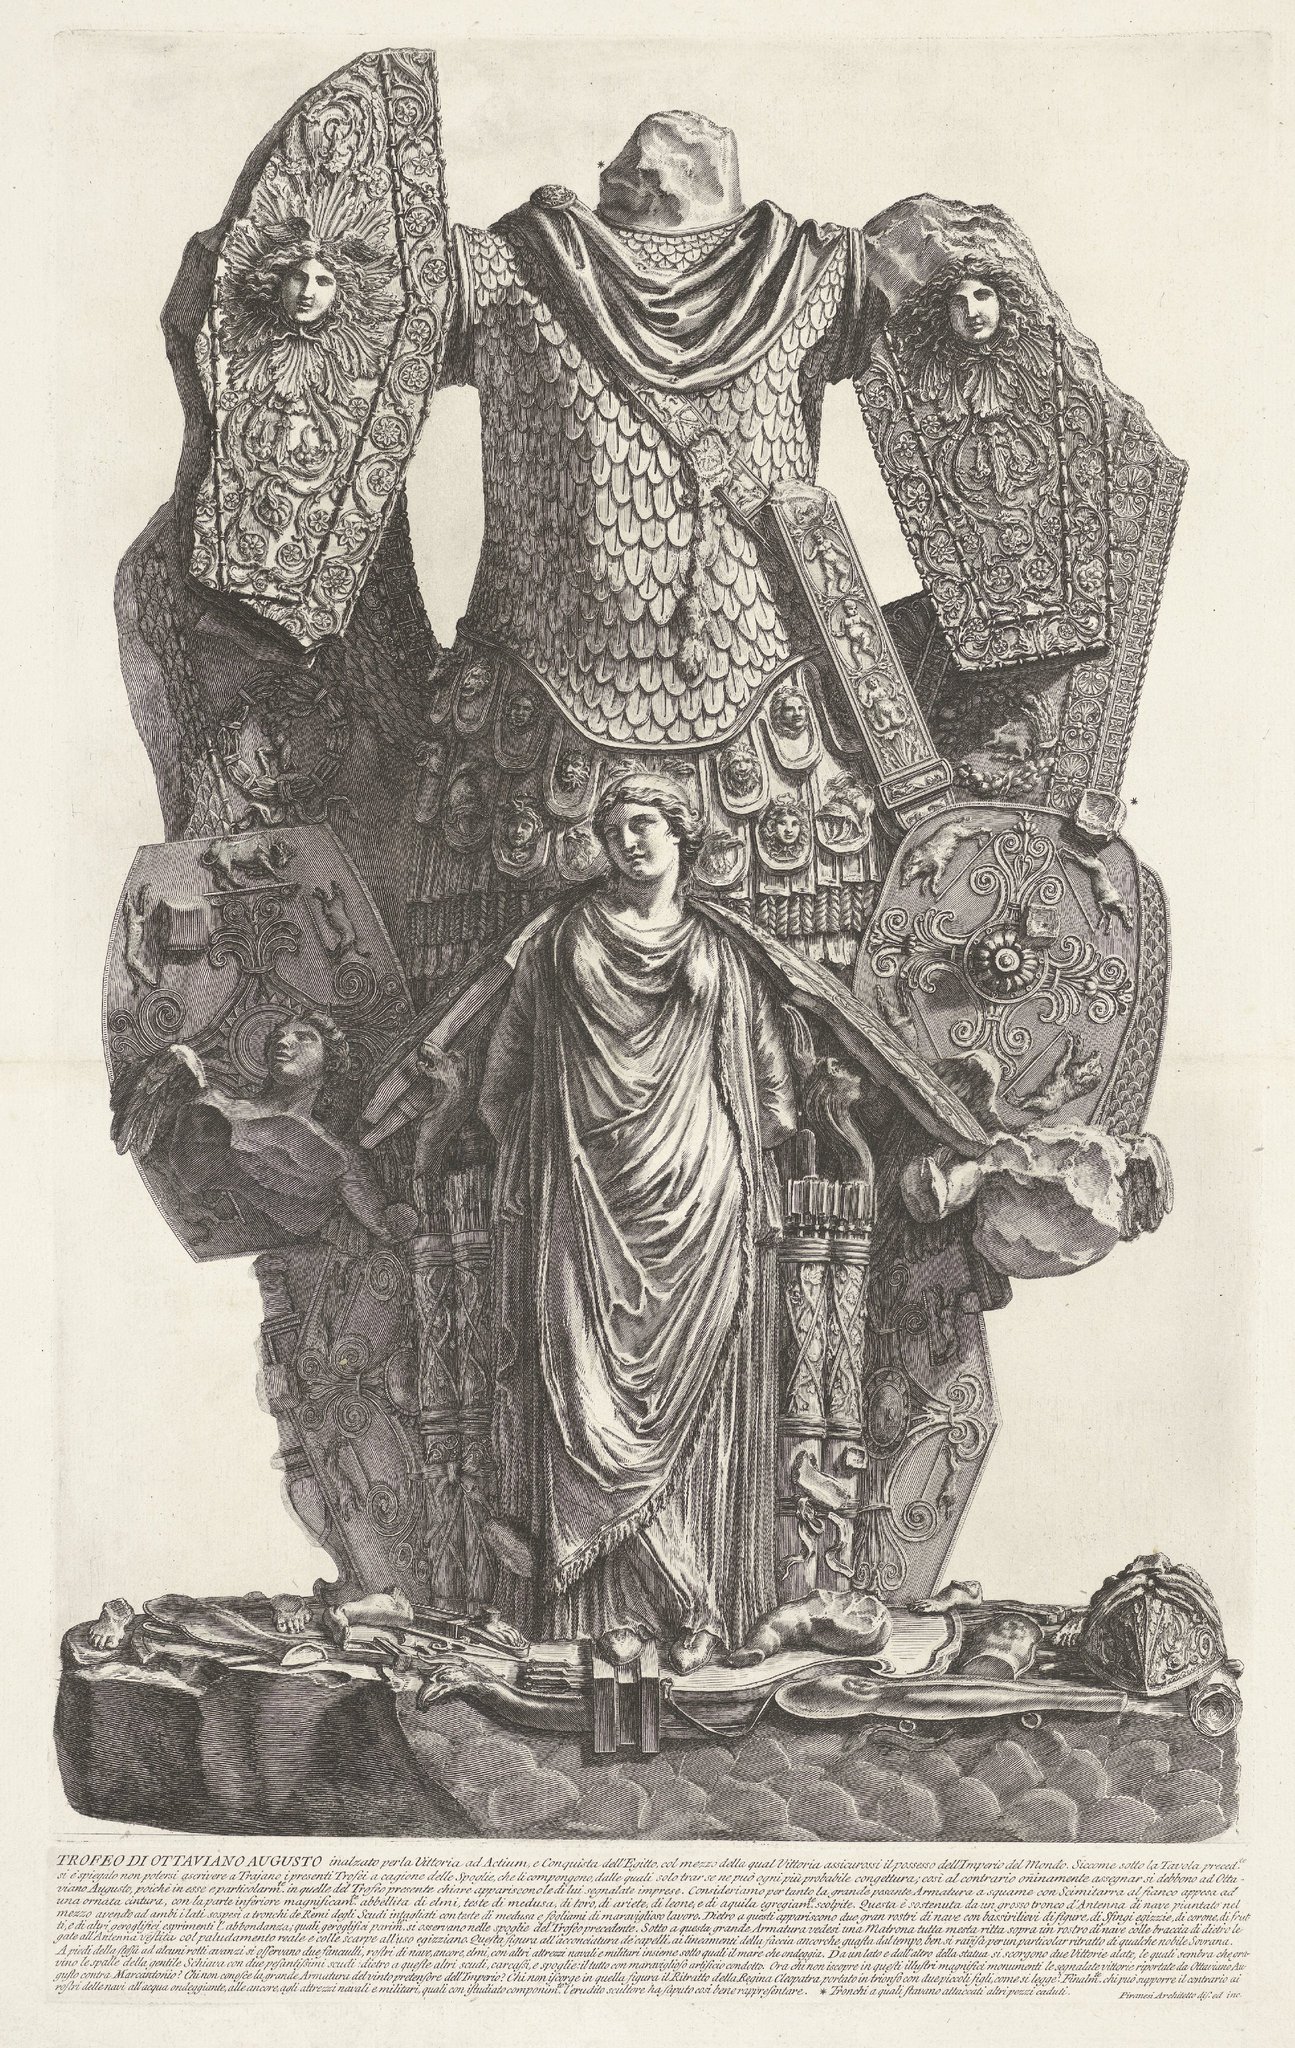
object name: print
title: Trofee van Octavianus Augustus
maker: giovanni battista piranesi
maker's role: designer, draughtsman, print maker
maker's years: 1720-1778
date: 1753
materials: paper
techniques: etching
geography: rome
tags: piece of sculpture, reproduction of a piece of sculpture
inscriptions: collector's mark: Lugt 2228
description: Een trofee van Octavianus Augustus. Een gebeeldhouwd reliëf met een vrouwelijke figuur omgeven door harnas en schilden. Titel en tekst in ondermarge.